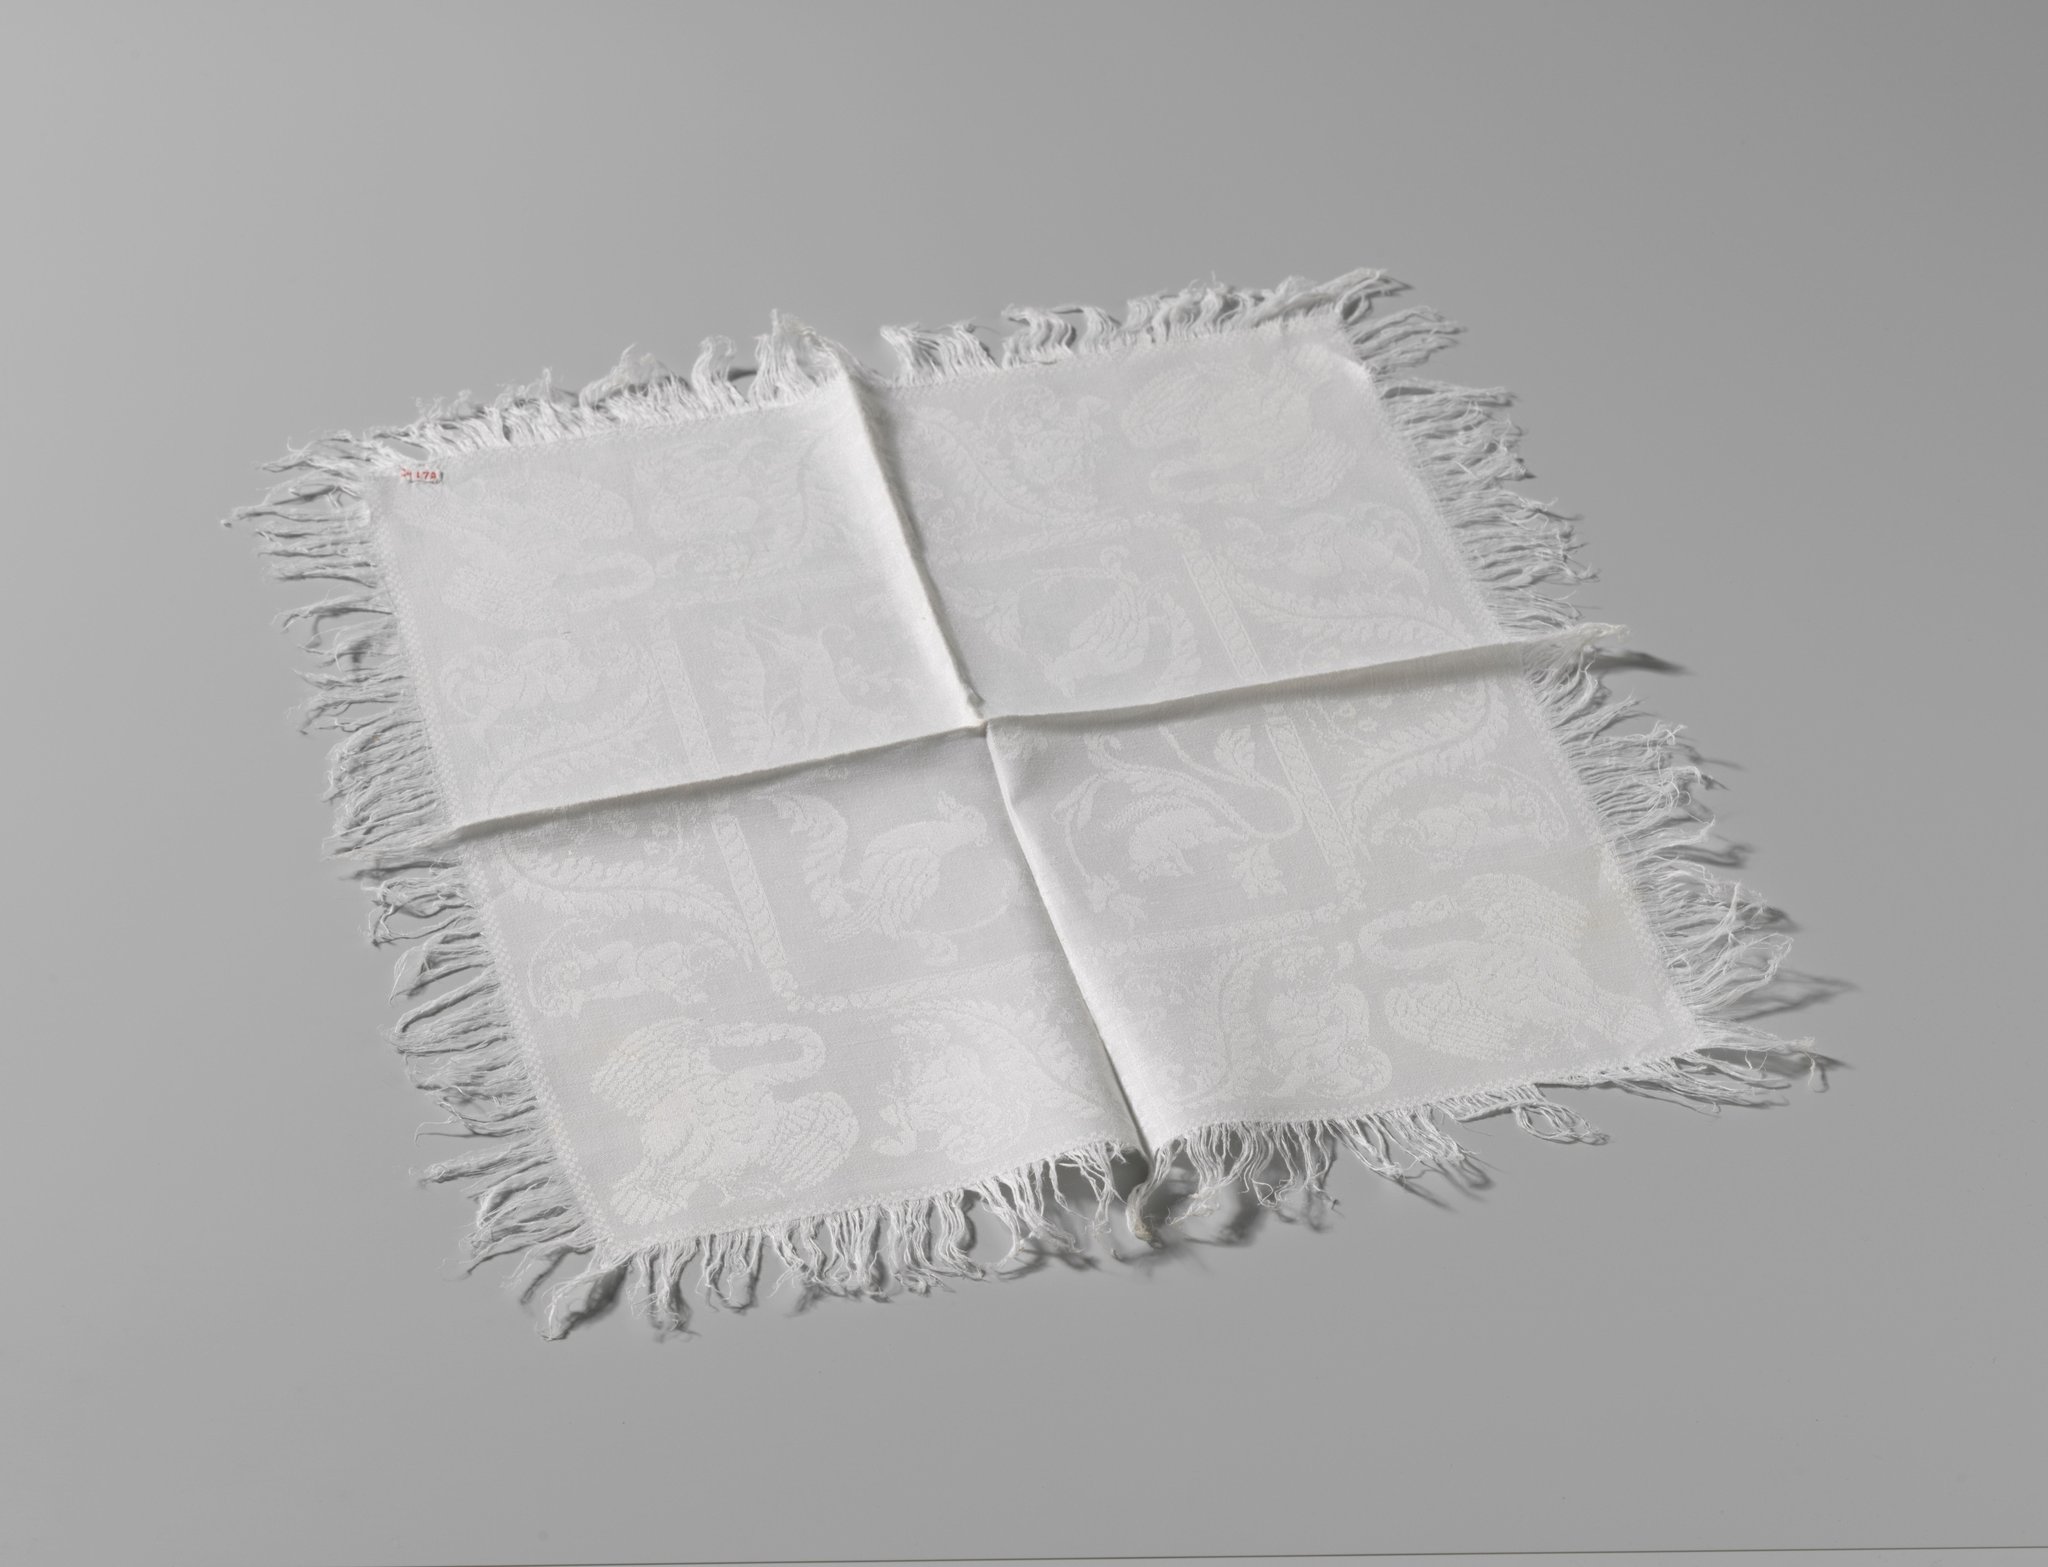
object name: napkin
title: Pijprokende Turken.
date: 1850-1899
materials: linen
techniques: damask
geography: veghel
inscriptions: label: ‘1172’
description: Vingerdoek van wit linnendamast, met dessin van pijprokende Turken.